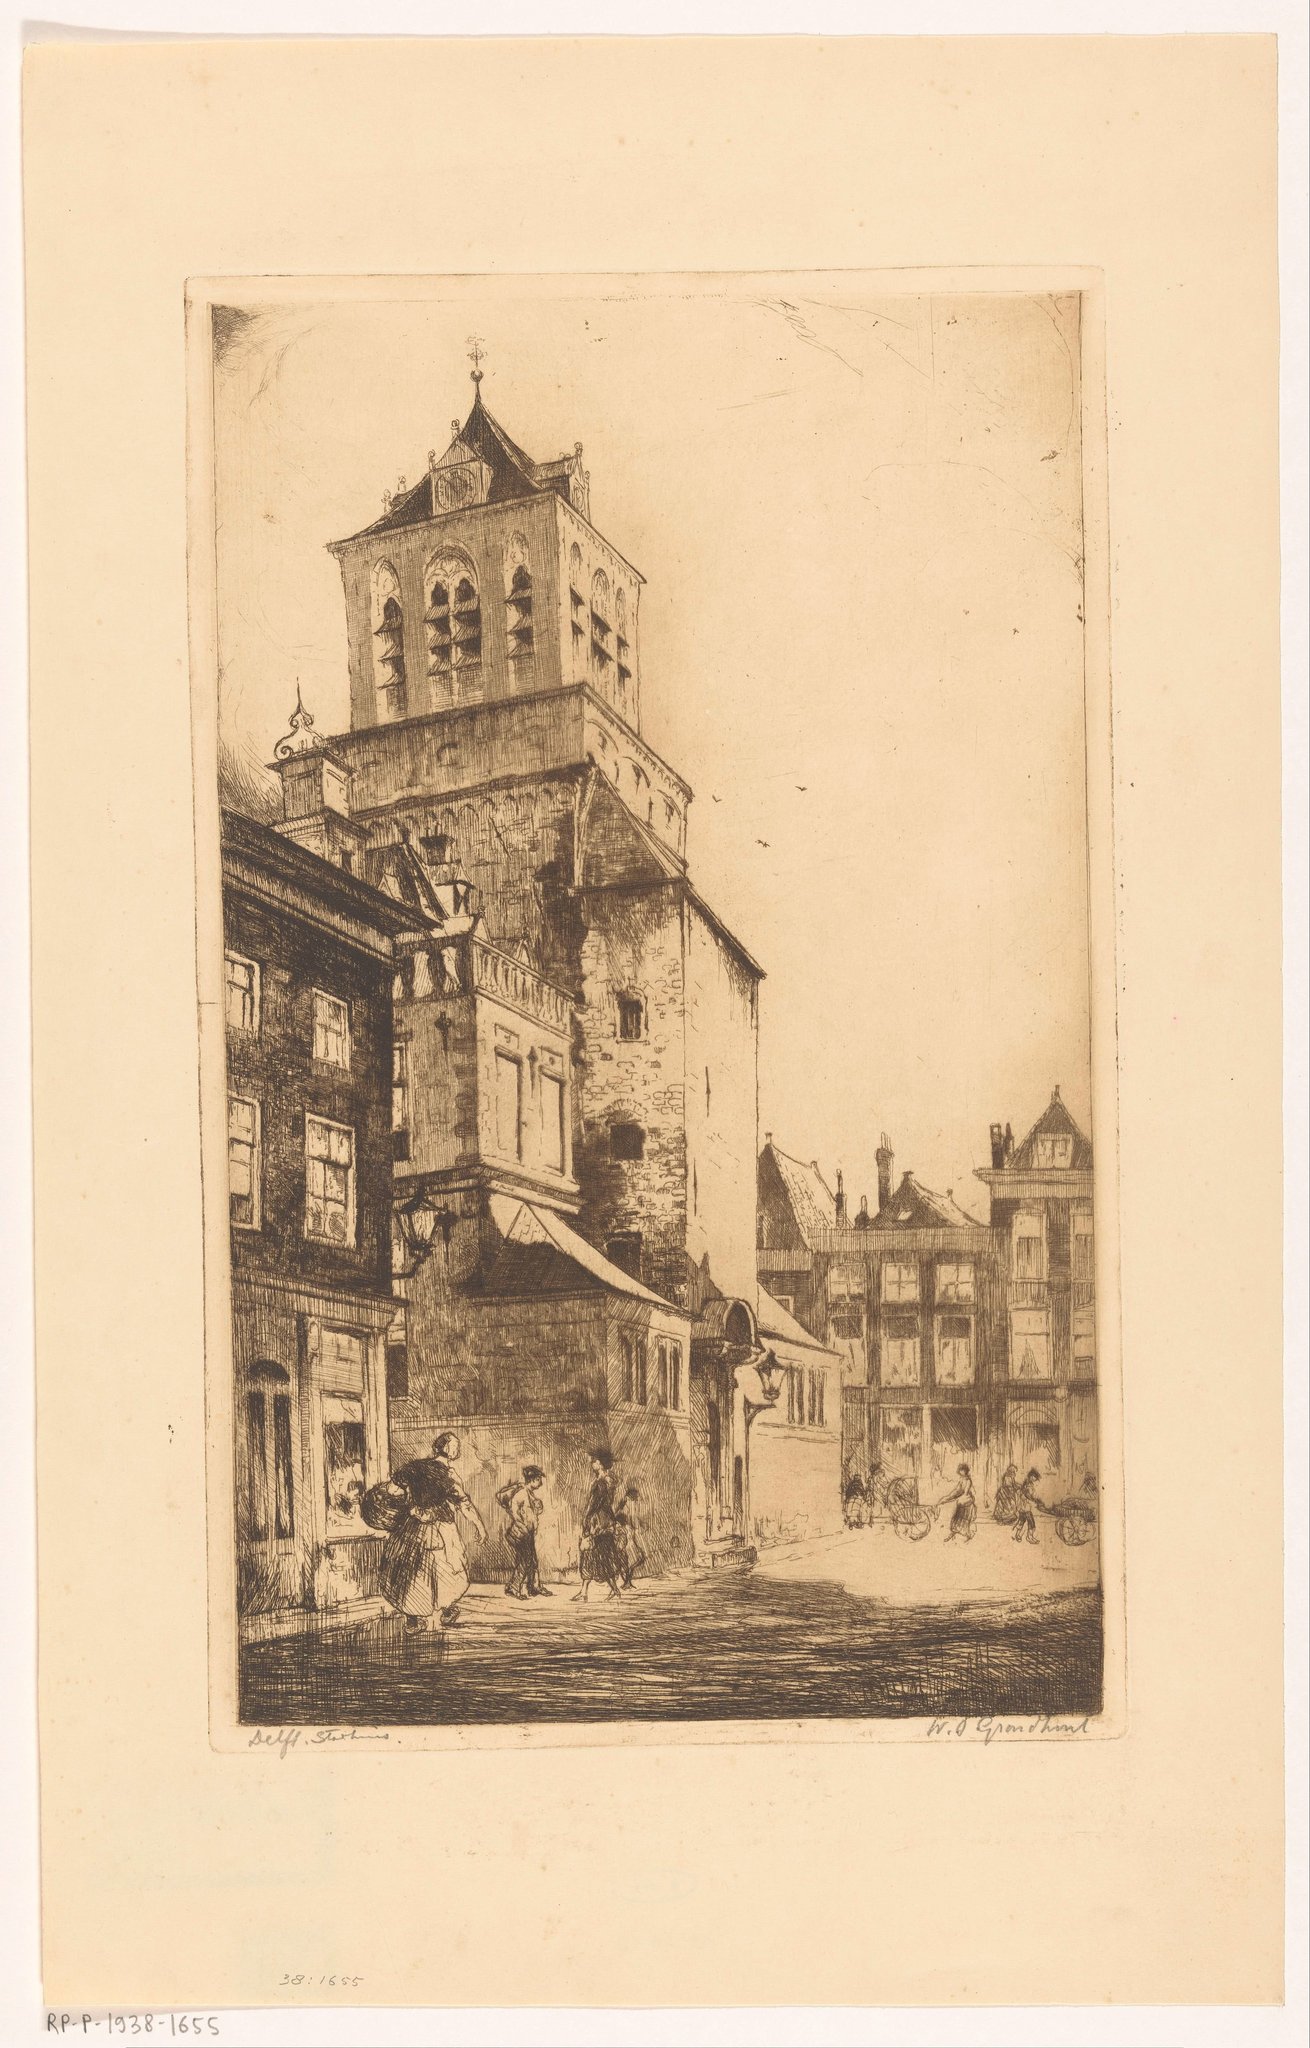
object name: print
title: Stadhuis van Delft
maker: willem adrianus grondhout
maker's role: draughtsman, painter, print maker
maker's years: 1878-1934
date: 1888-1934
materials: paper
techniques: etching, intaglio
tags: townhall, street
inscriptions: collector's mark: Lugt 2228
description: Figuren wandelen op straat bij de achterzijde van het stadhuis van Delft.